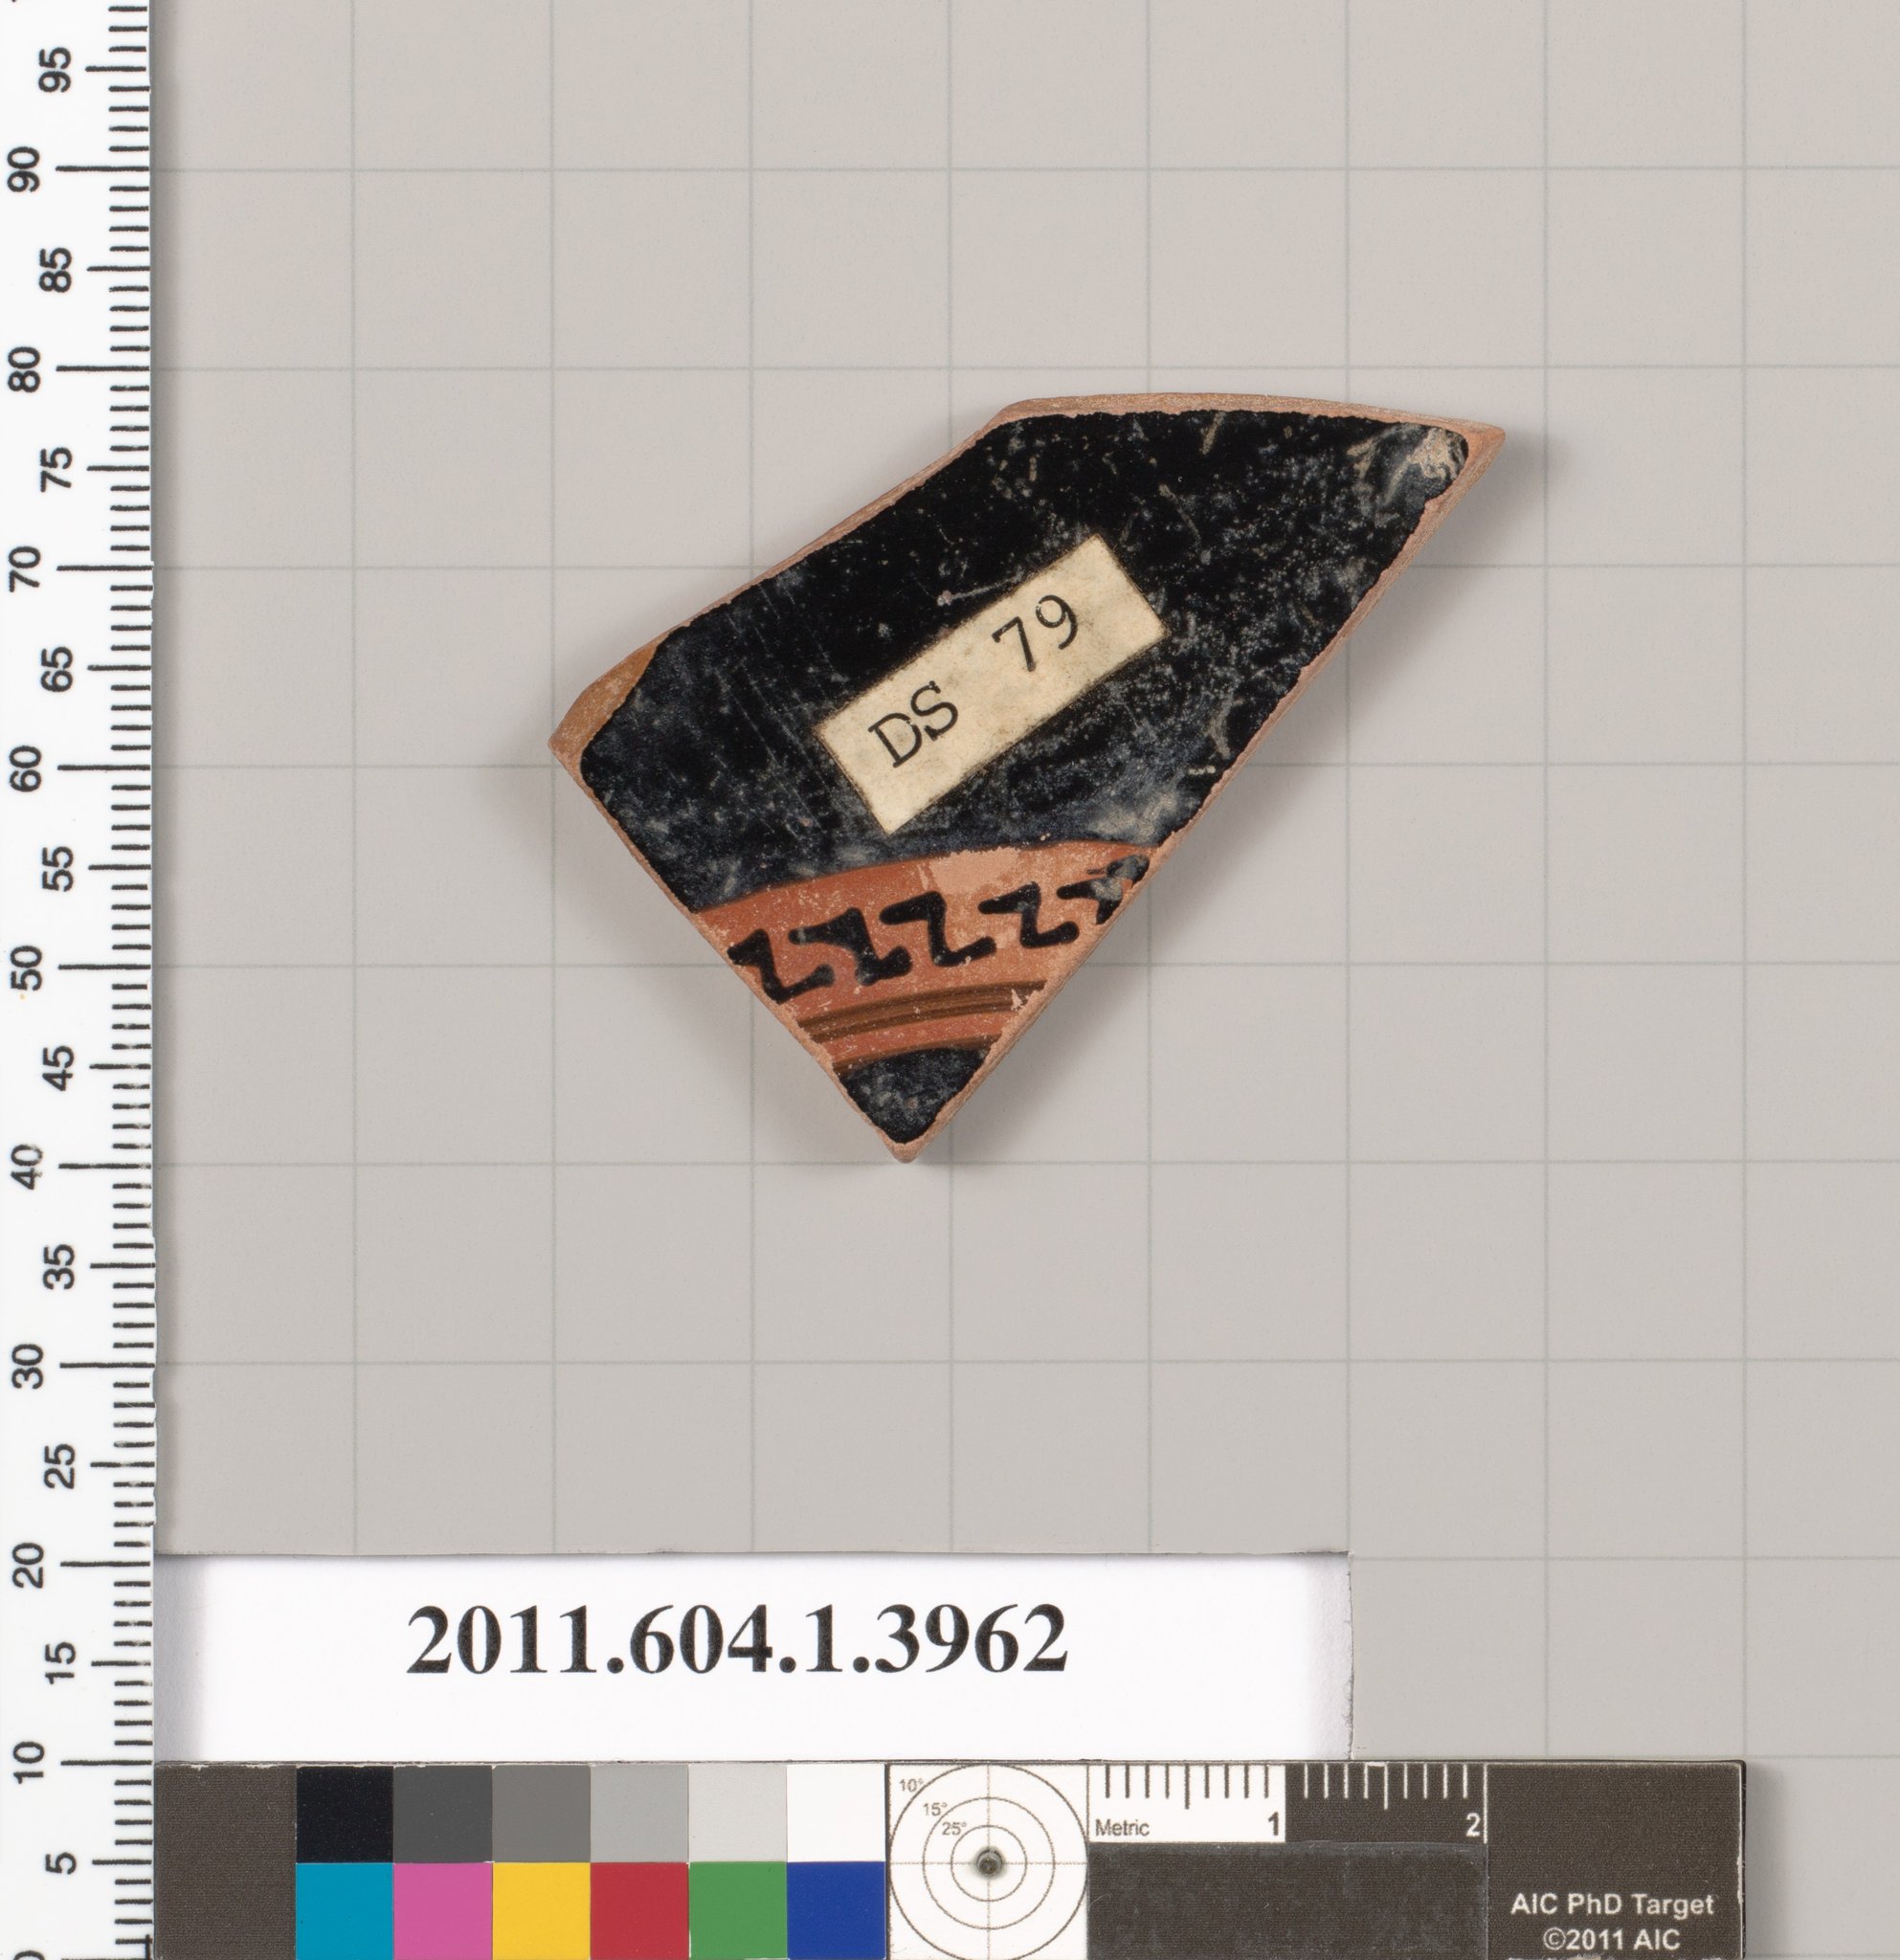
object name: kylix fragment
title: Terracotta fragment of a kylix (drinking cup)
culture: greek, attic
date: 475-451 BCE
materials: terracotta